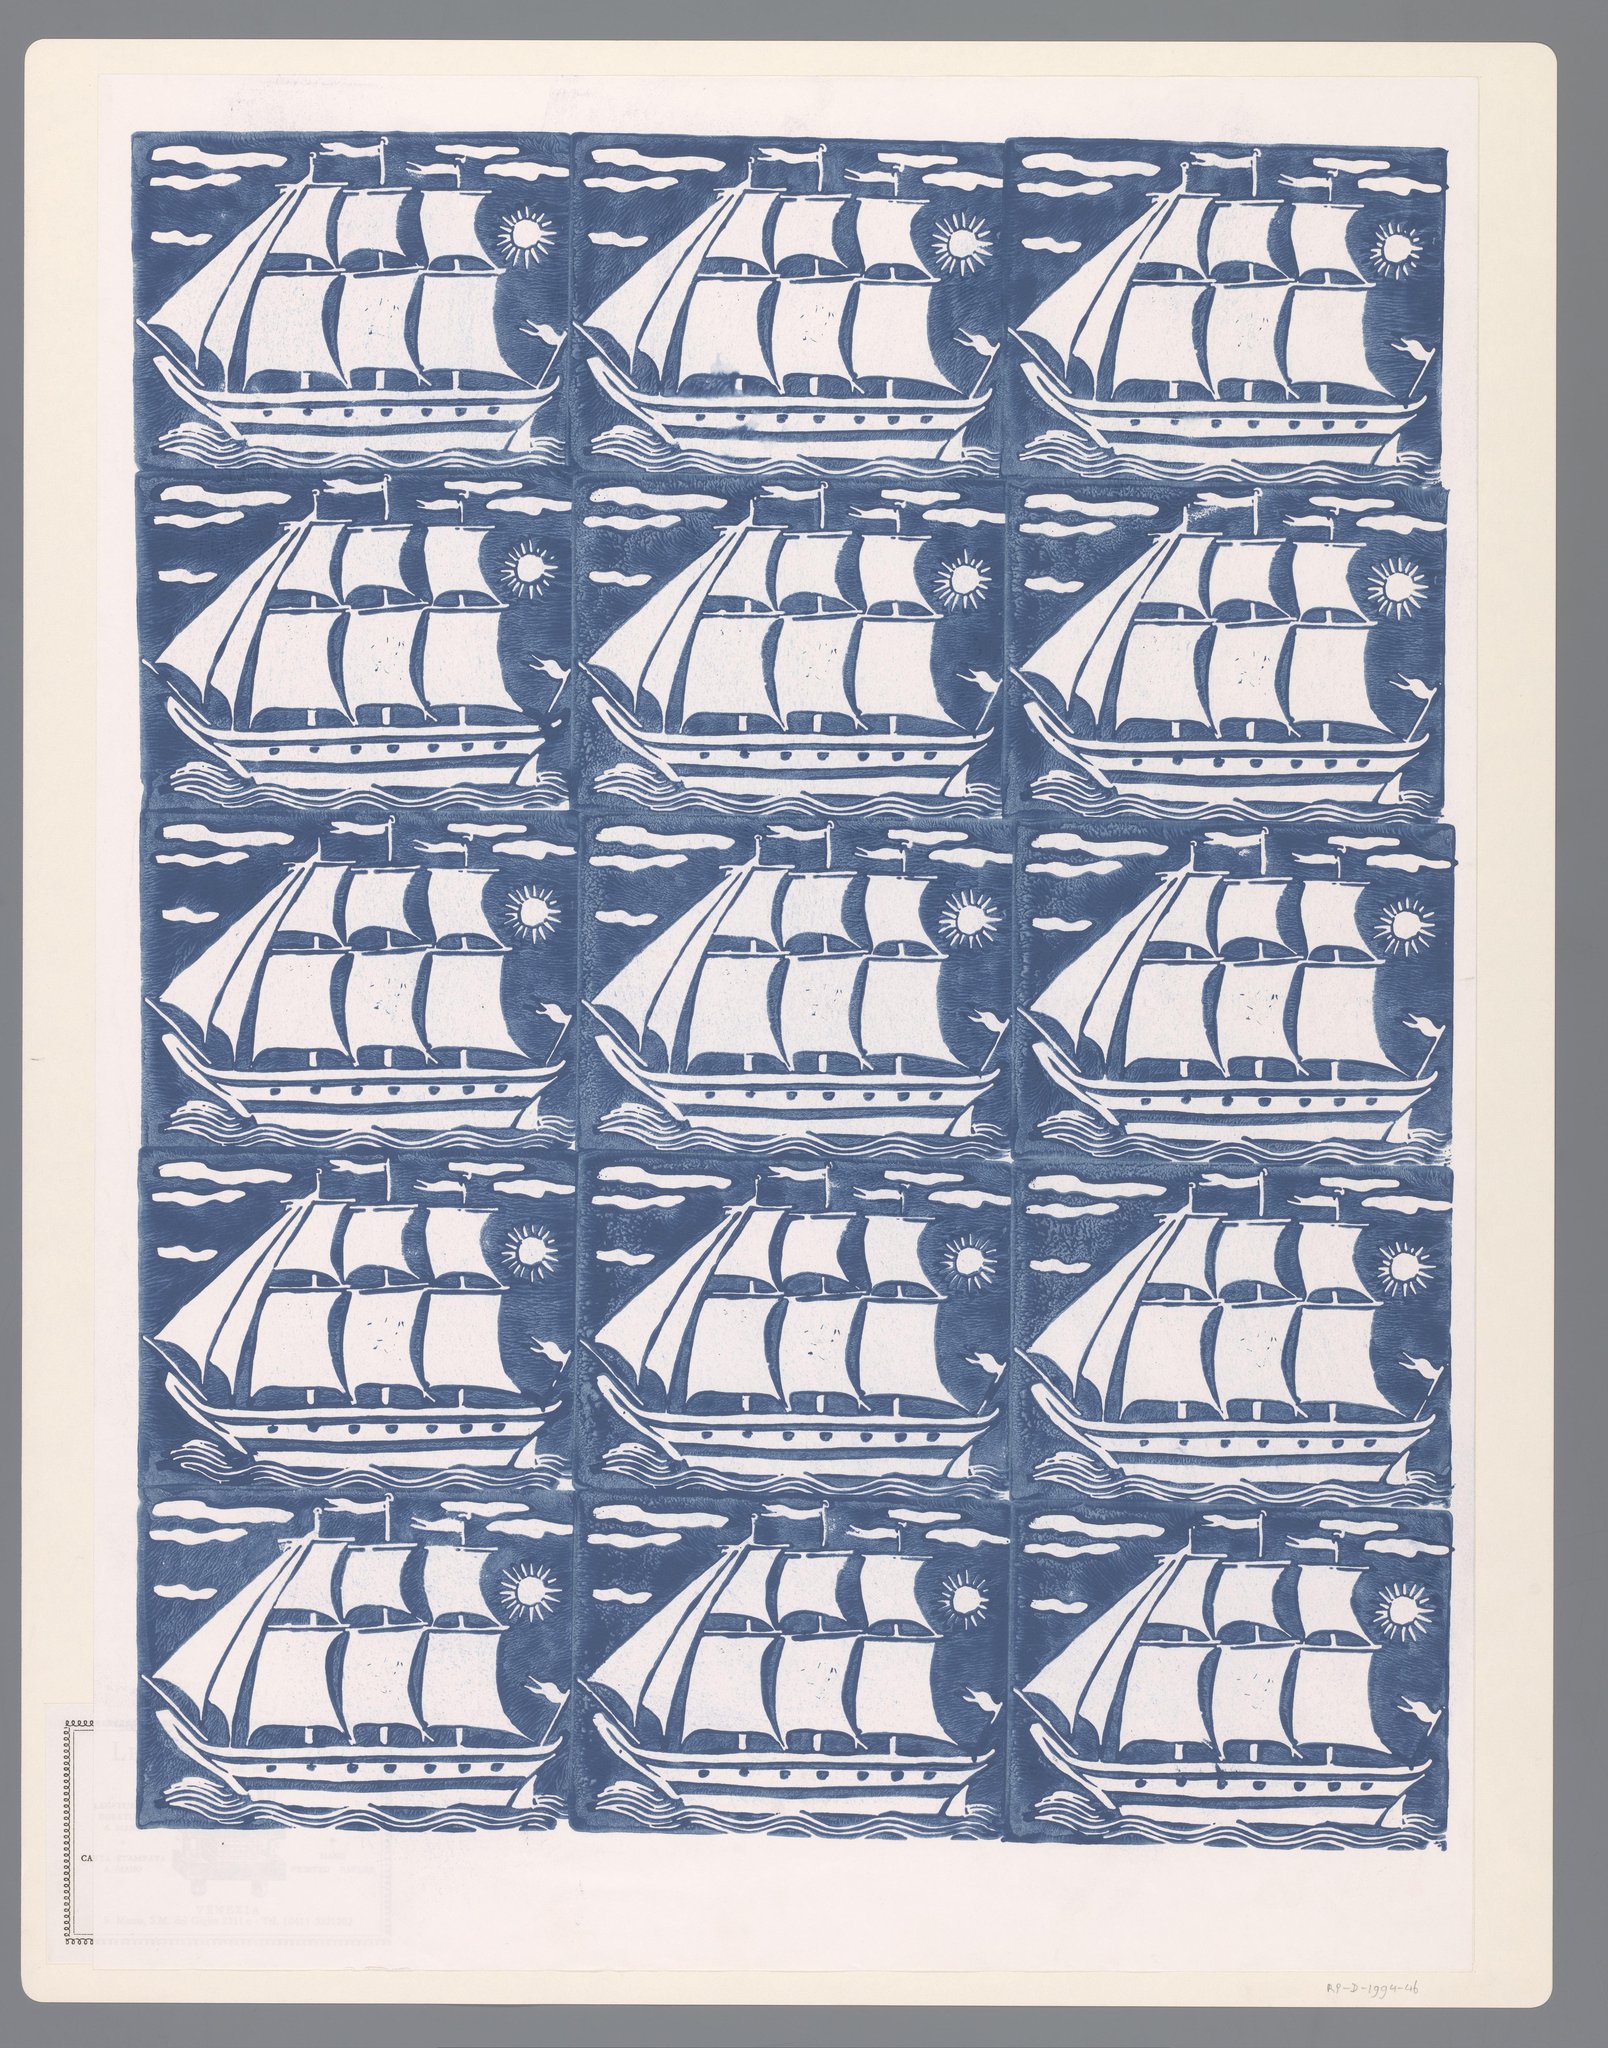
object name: printed paper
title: Blad met zeilschepen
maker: legatoria piazzesi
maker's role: printer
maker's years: 1905-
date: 1990-1994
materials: paper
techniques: printing block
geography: venice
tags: sailing-ship, sailing-boat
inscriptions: collector's mark: Lugt 2228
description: Blad met patroon in vijf rijen met drie varende zeilschepen op een blauw fond.